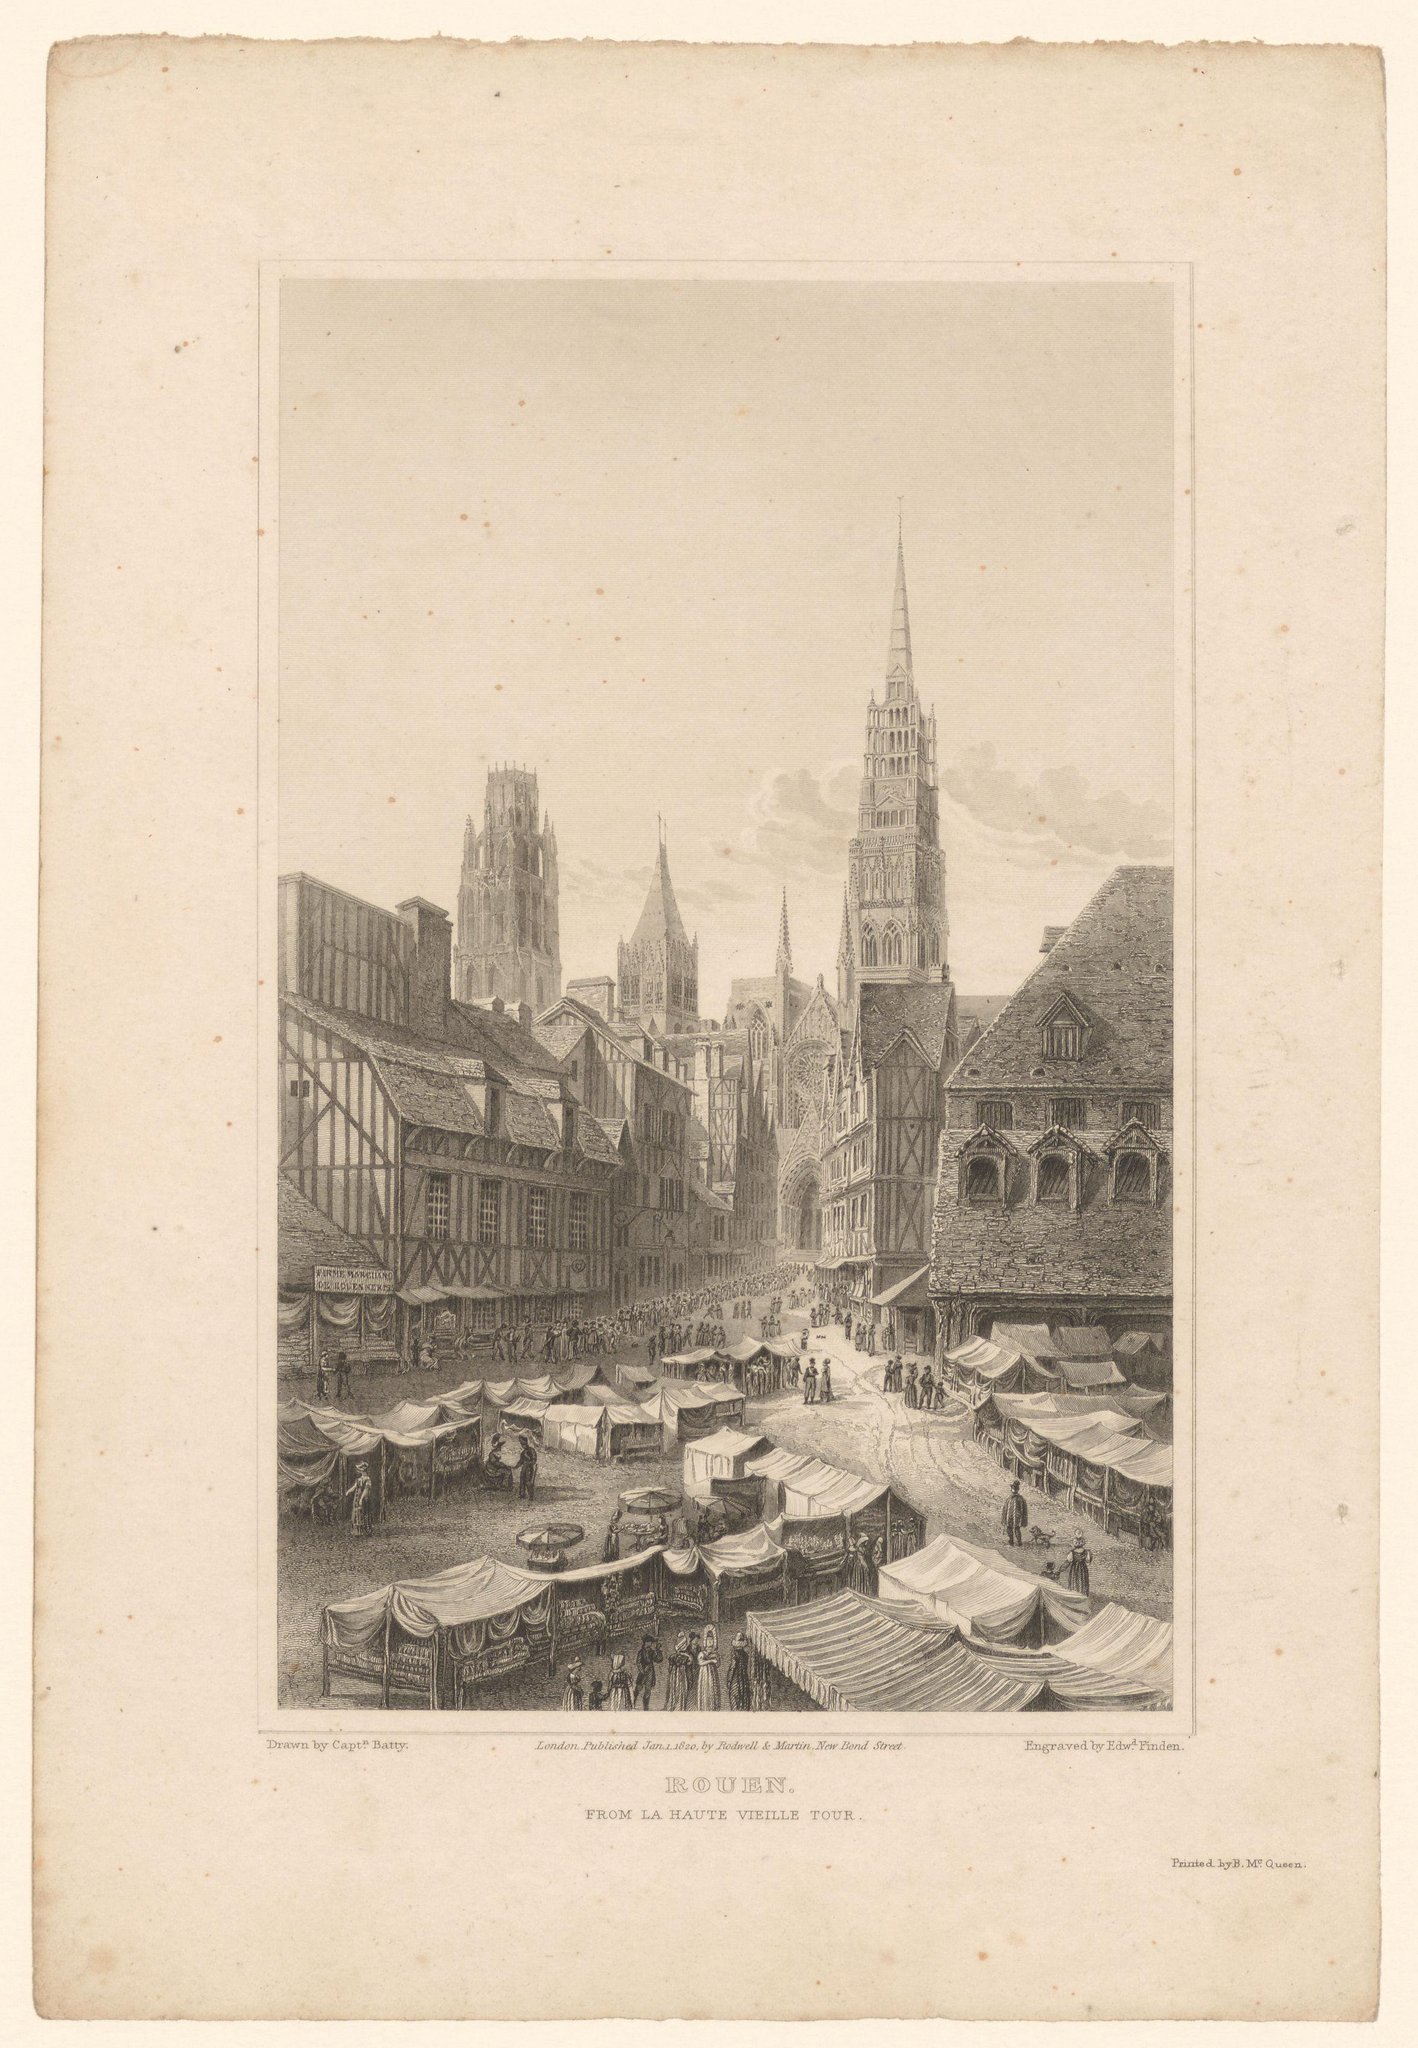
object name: print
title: Rouen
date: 1801-1820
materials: paper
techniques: etching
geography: london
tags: church (exterior), market, square, place, circus, etc. (+ city(-scape) with figures, staffage)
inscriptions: collector's mark: Lugt 2228